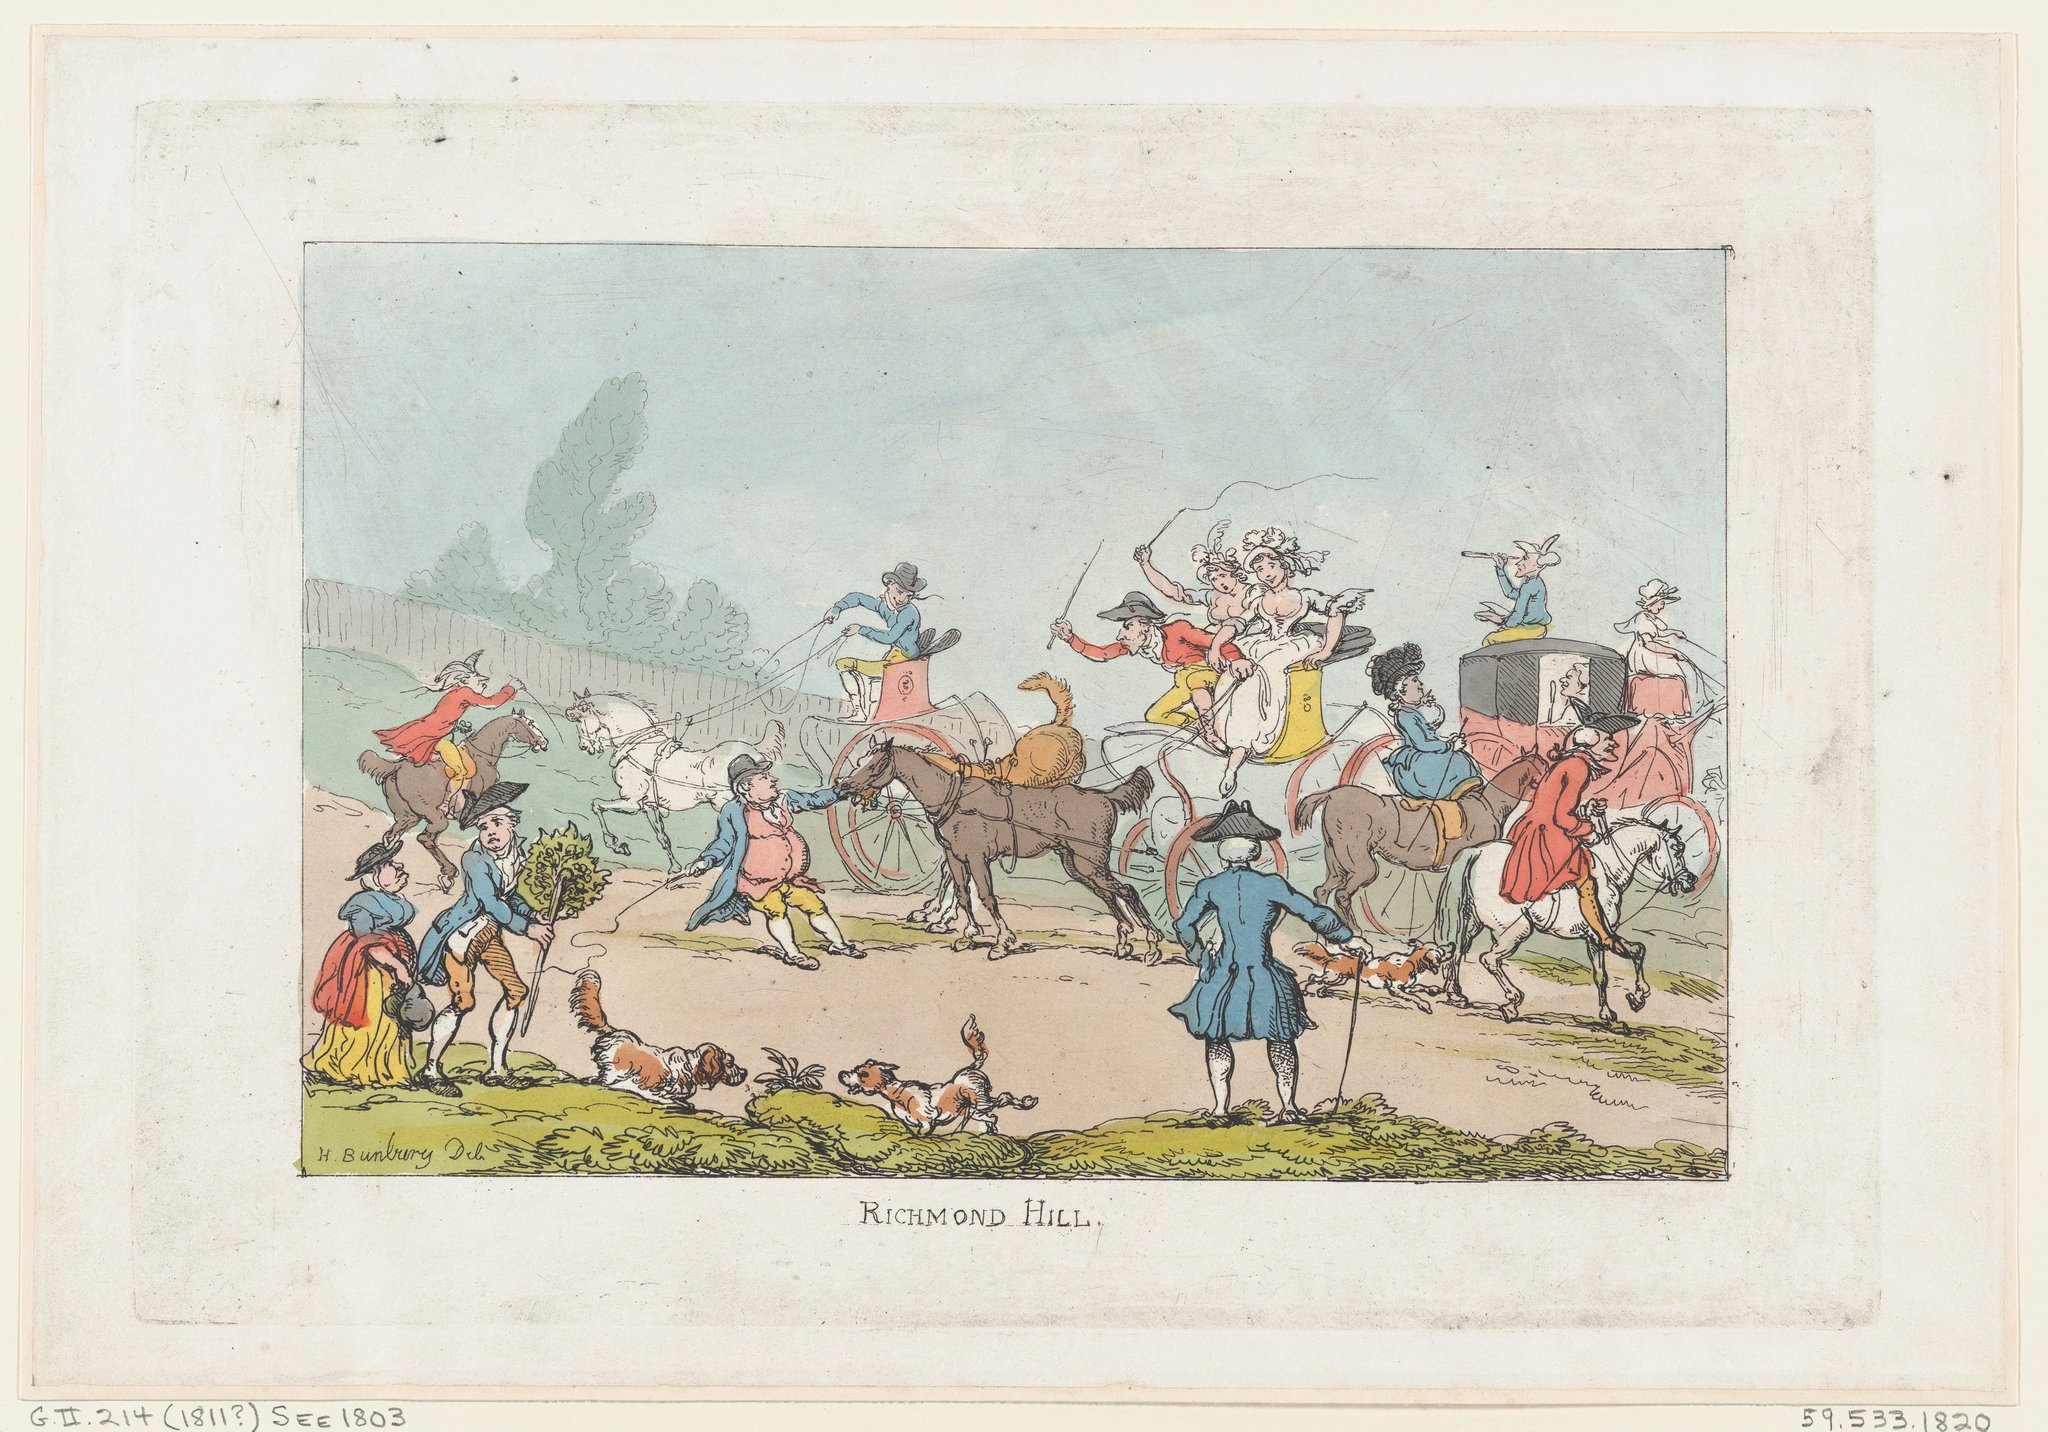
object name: print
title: Richmond Hill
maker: thomas rowlandson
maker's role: artist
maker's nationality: british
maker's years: 1757-1827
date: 1811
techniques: etching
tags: satire,men,women,horses,carriages